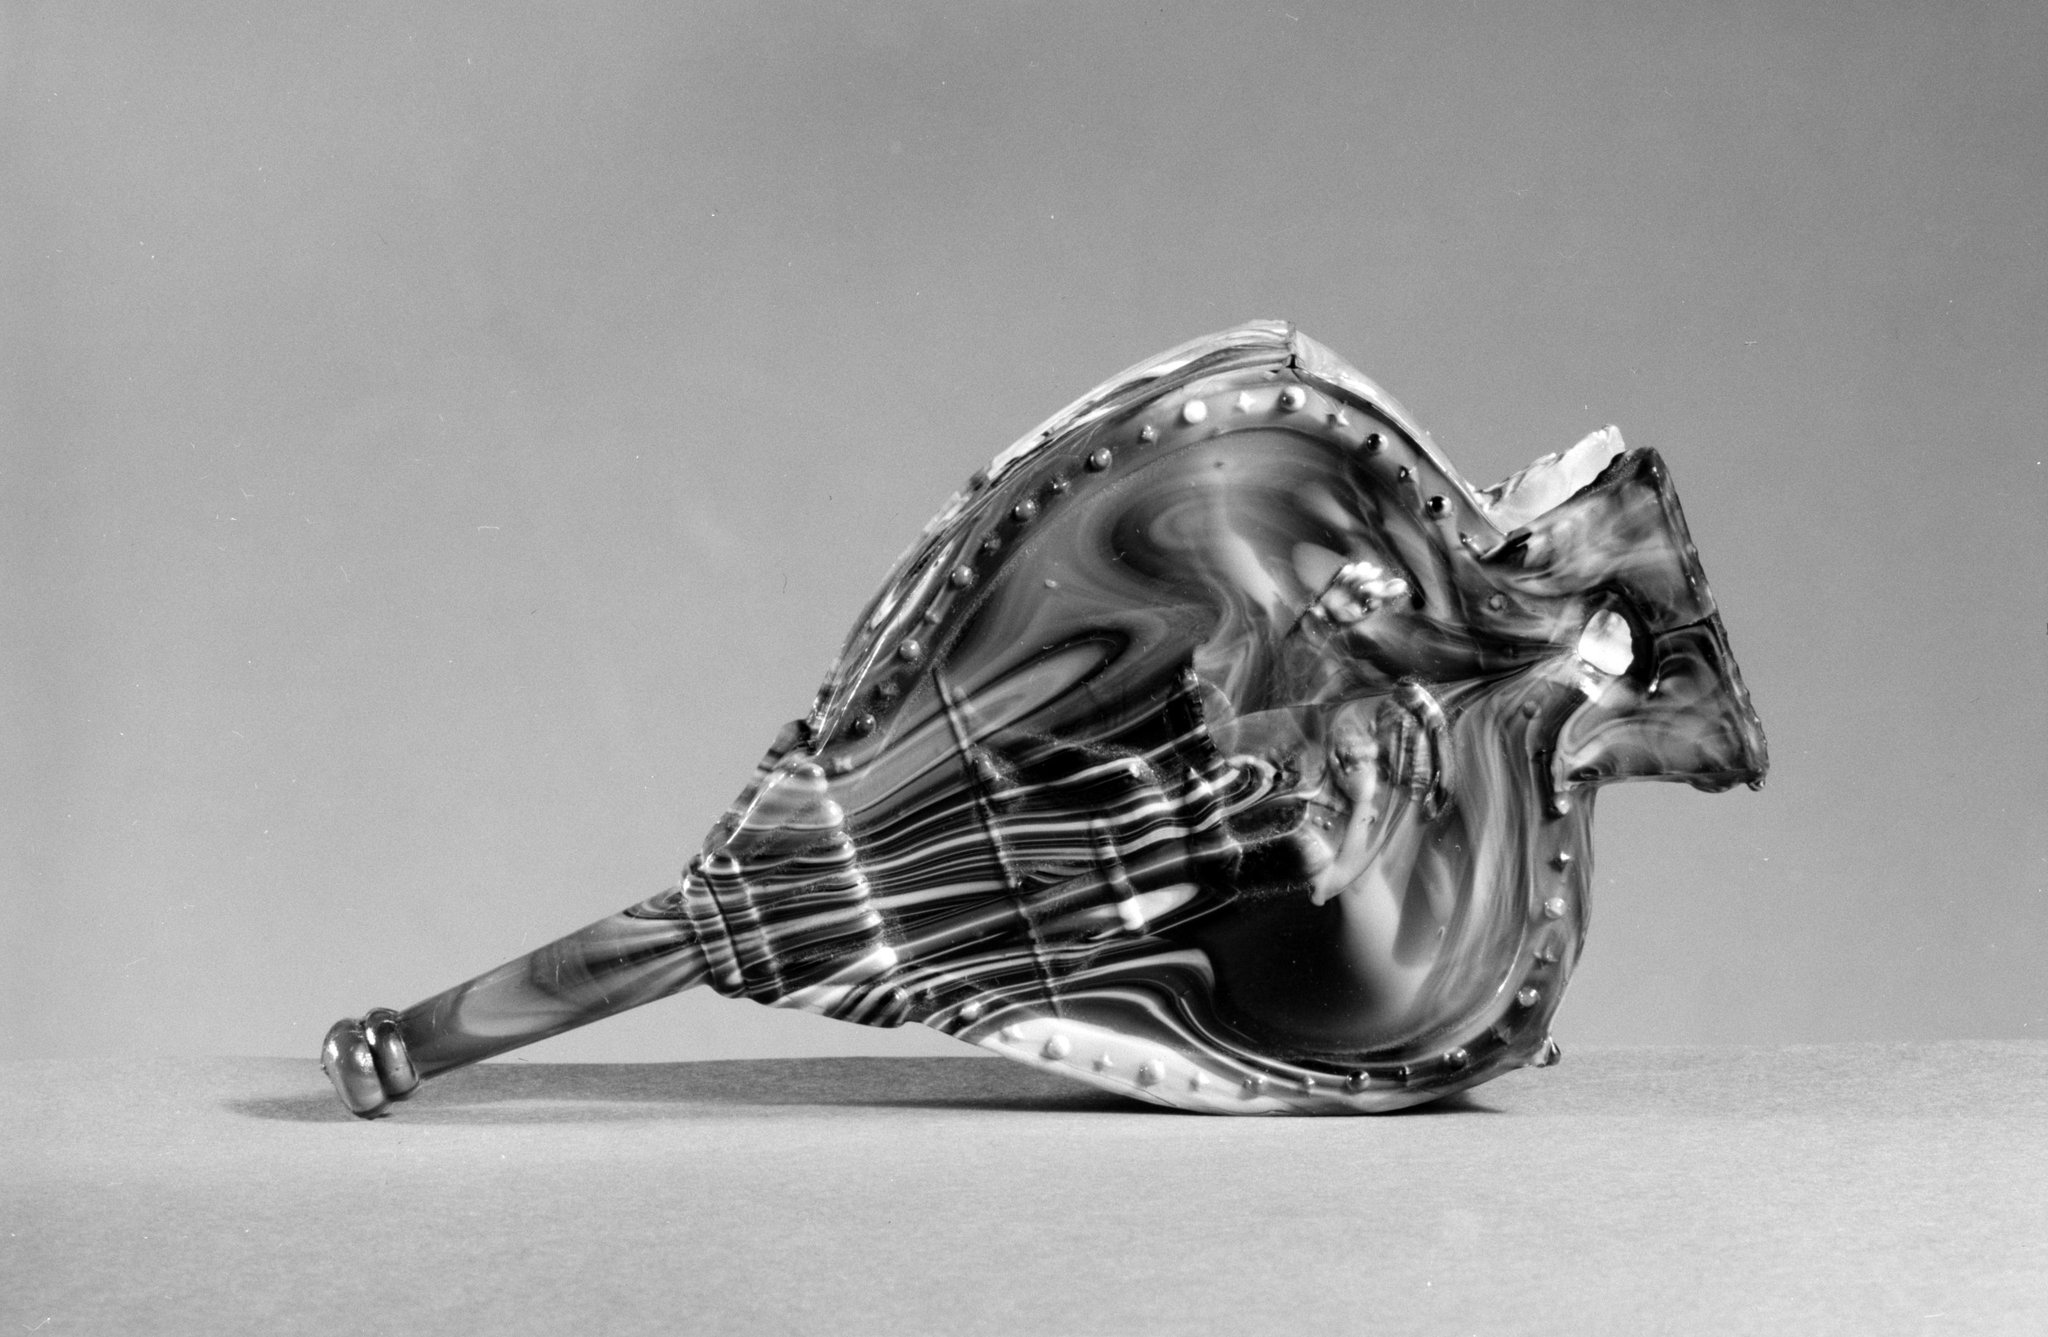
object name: bellow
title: Bellows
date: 1880-1890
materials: glass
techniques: pressed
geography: england